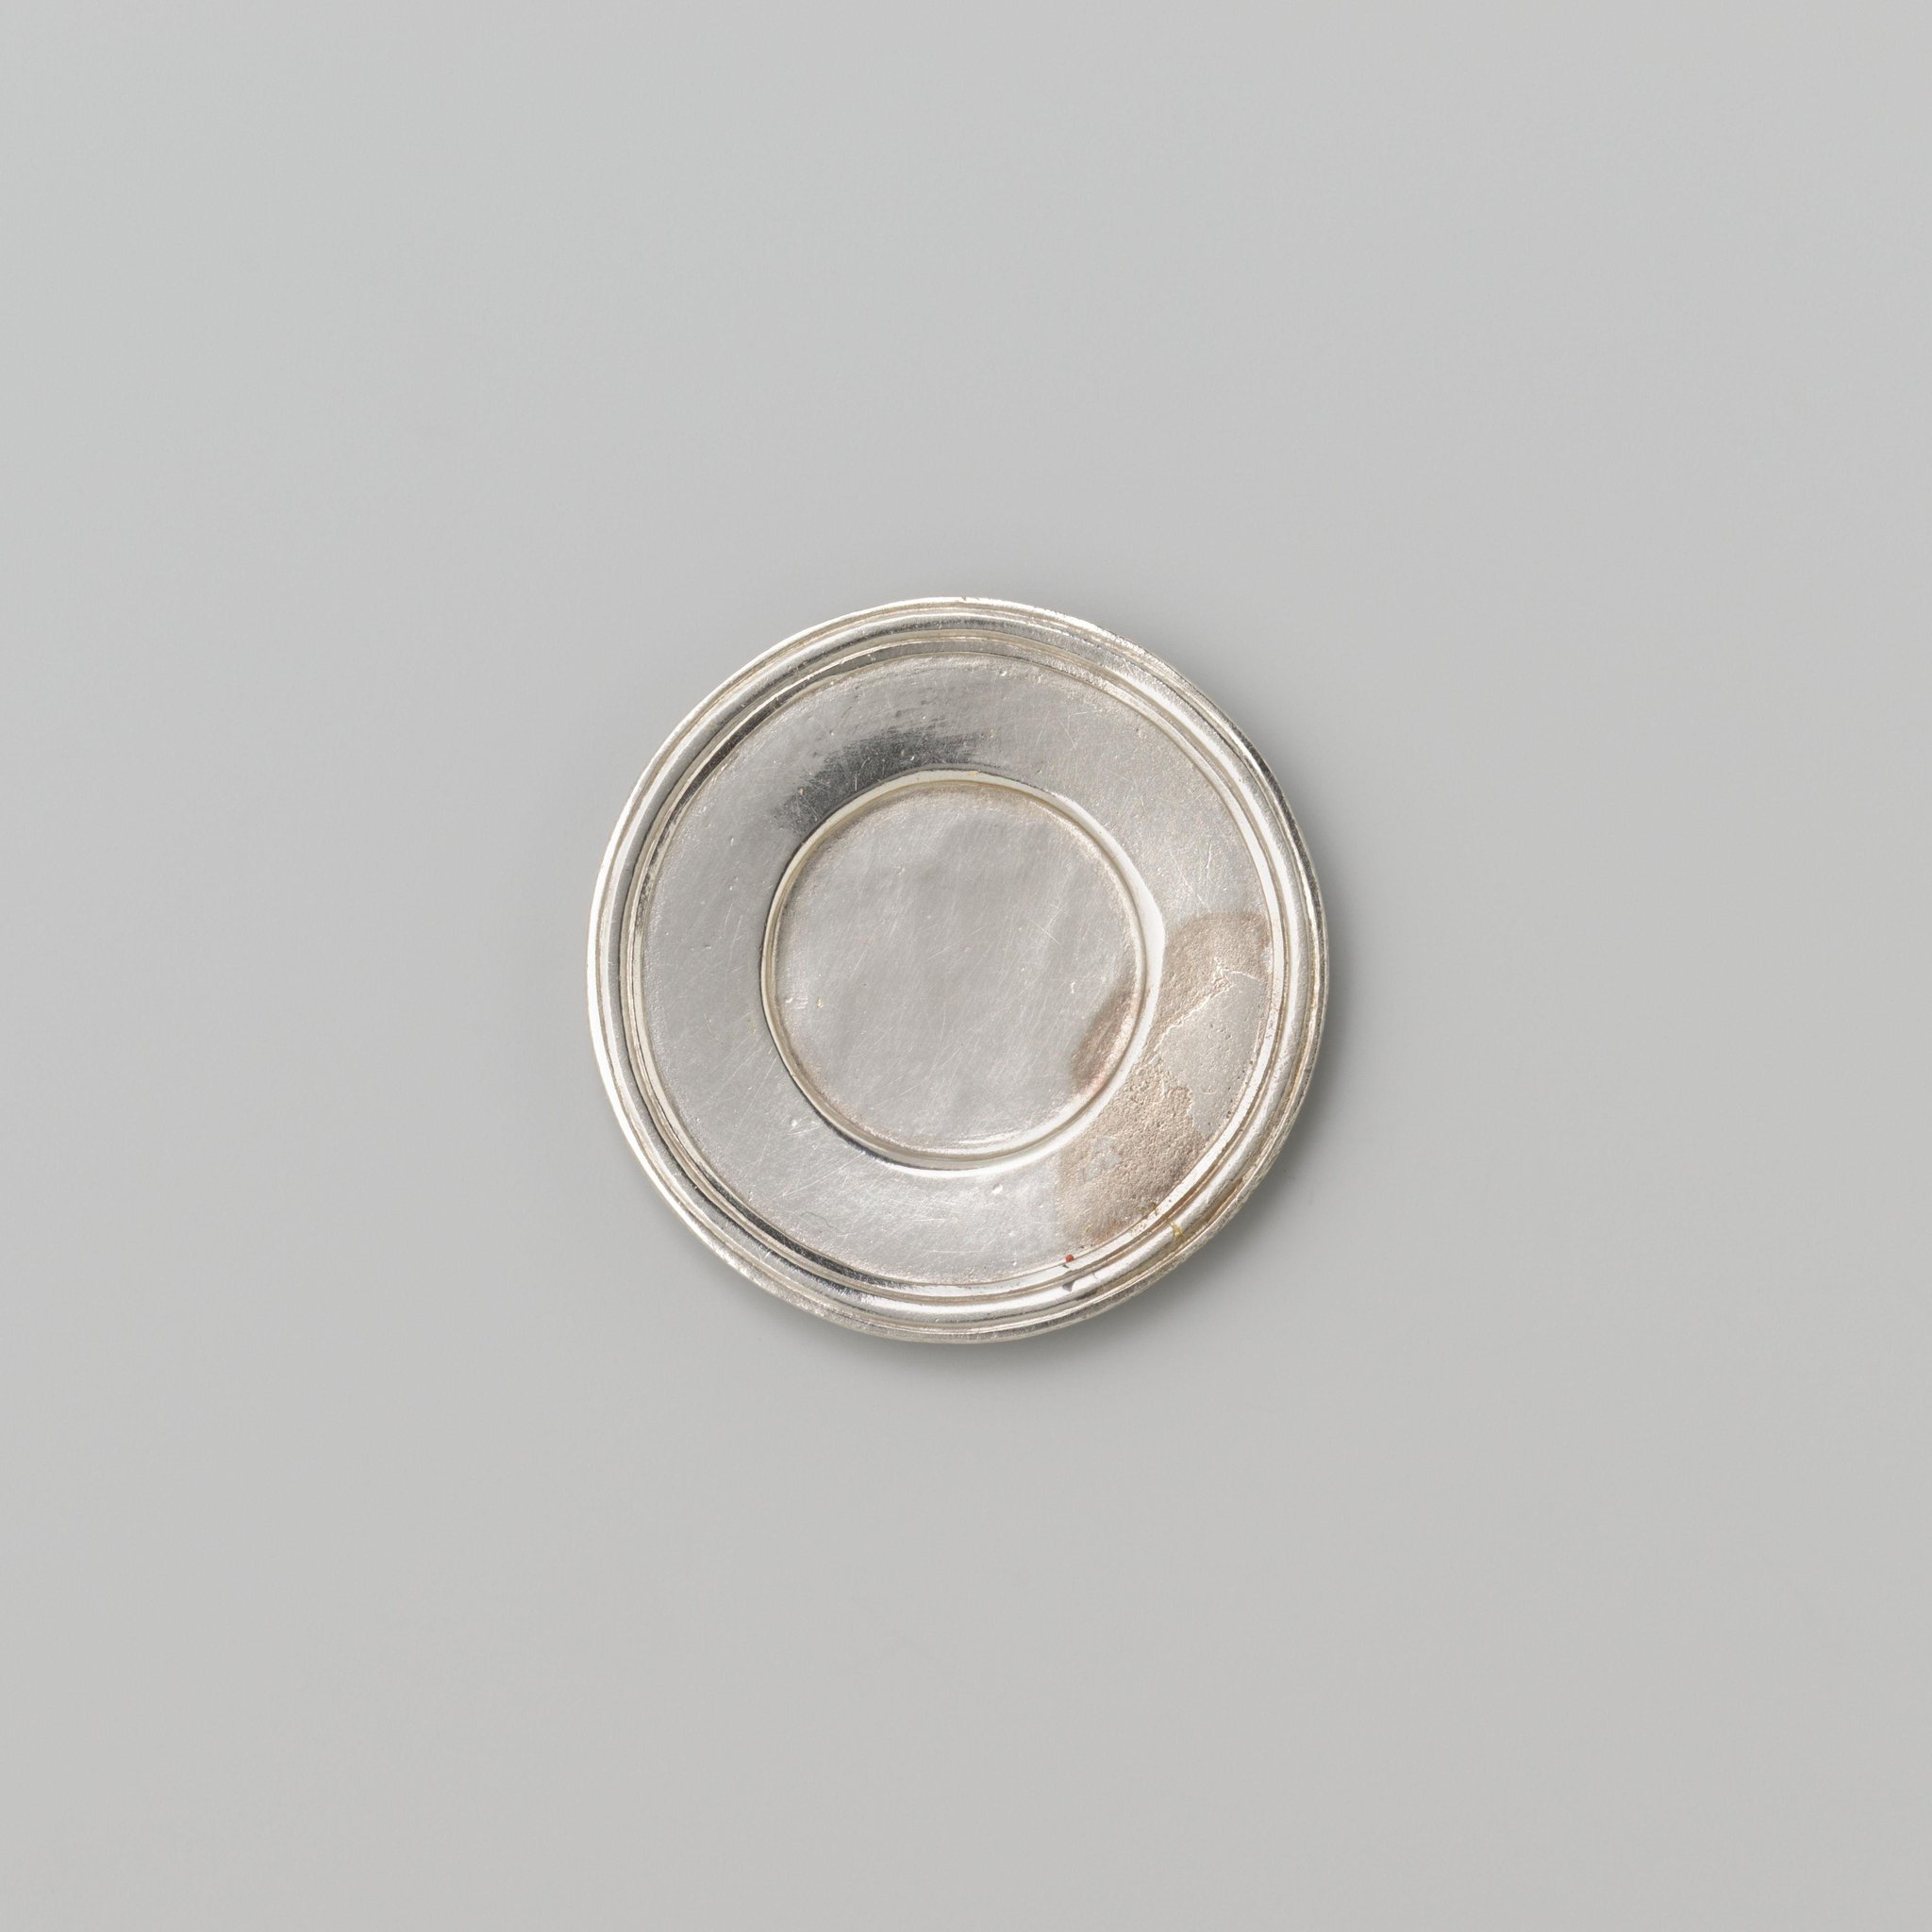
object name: miniature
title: Zilverkleurige schoteltje met brede platte geprofileerde rand.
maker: Anonymous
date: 1700-1710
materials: copper alloy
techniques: silvering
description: Zilverkleurige schotel met brede, platte geprofileerde rand.